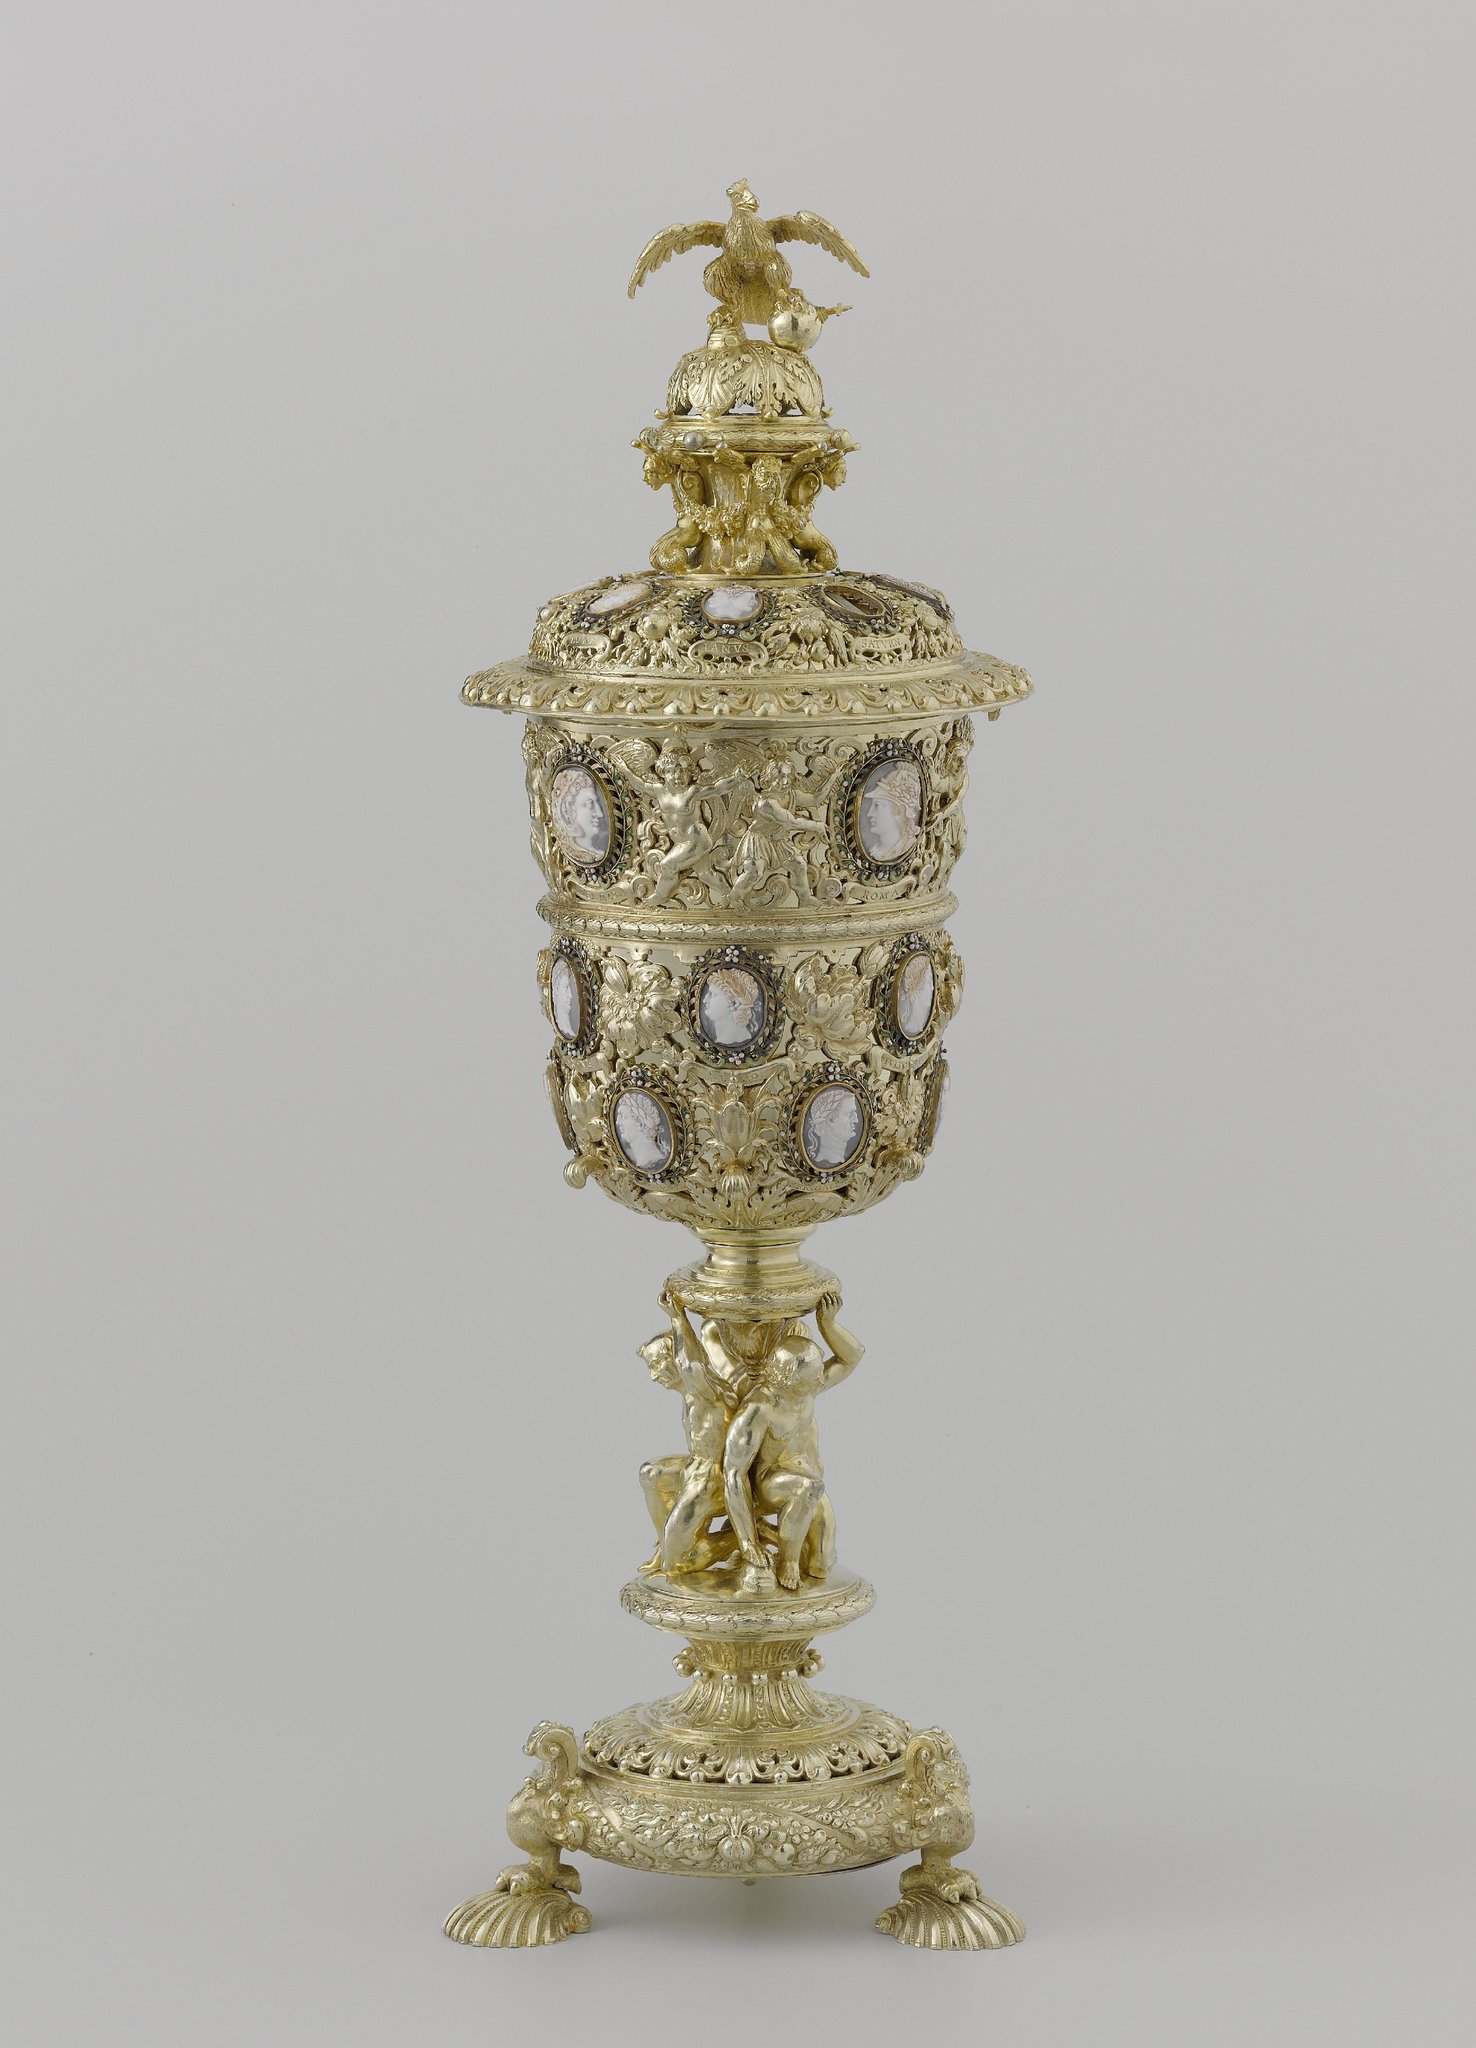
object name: goblet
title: Goblet with cameos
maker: abraham valck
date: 1625-1626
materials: silver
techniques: embroidery, gilding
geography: antwerp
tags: predatory birds: eagle, ornament derived from plant forms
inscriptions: maker's mark, date letter, stamp, town mark, inscription: ‘MINUS.; CYRUS.; ALEX. MAG.; ROMA.; IULIUS CAES.; AUGUSTUS.; TIBERIUS.; C. CALIGULA.; CLAUDIUS.; NERO.; SER. GALBA.; OTTO; VITELLIUS.; VESPASIANUS; TITUS. DOMITIANUS’, inscription: ‘IANUS; SATURN.; IUPITER; SOL; MERCUR.; MARS; VENUS; LUNA’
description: This exceptionally lavish cup is decorated with ancient cameos – relief carvings in banded or stratified quartz. The lid is set with images of Classical gods, while those on the goblet have profile portraits of ancient rulers and Roman emperors.